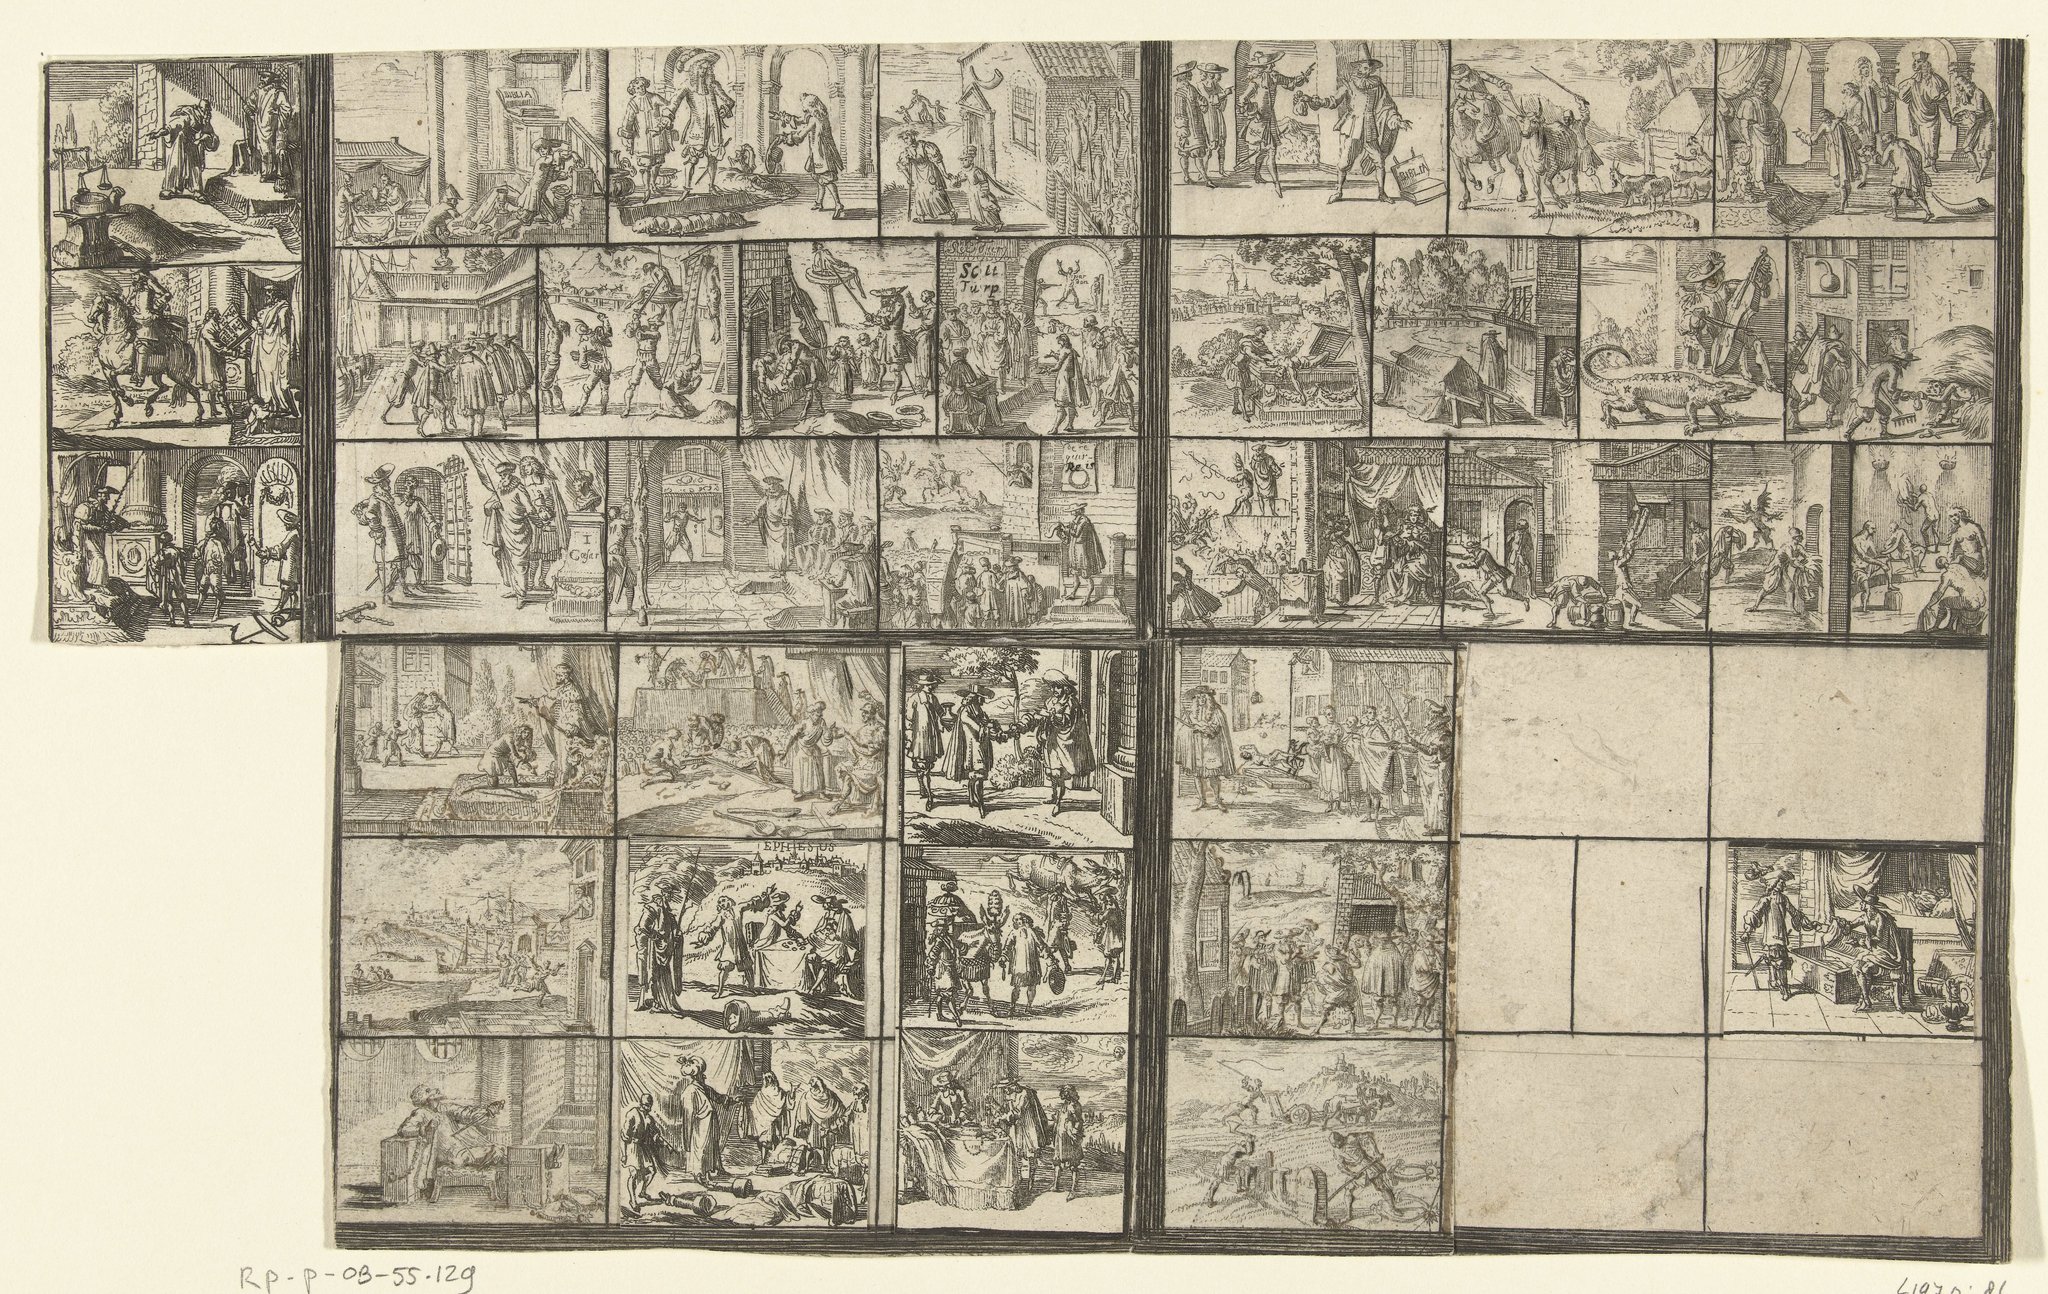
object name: print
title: Bladen met tientallen kleine voorstellingen van juridische aard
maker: romeyn de hooghe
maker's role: draughtsman, goldsmith, painter, print maker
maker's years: 1645-1708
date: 1690-1695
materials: paper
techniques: etching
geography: haarlem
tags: law and jurisprudence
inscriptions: collector's mark: Lugt 2228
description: Twee aan elkaar gelijmde delen van een blad dat waarschijnlijk oorspronkelijk een rechthoek was, onderverdeeld in tien vlakken, die zelf weer onderverdeeld waren in tien kleine vlakjes. In dit geval is een L-vormig deel vastgeplakt aan een klein rechthoekig deel, tezamen goed voor ruim vier vlakken, drieënveertig kleine vlakjes. Zestien van die kleine vakjes zijn leeg gelaten (in tien daarvan zijn uitgeknipte plaatjes van een ander blad geplakt), zevenentwintig zijn gevuld met kleine voorstellingen van juridische aard. Zo zijn er bijvoorbeeld transacties, contracten etc. afgebeeld. Dit blad is onderdeel van een serie bladen met telkens (ruimte voor) tien maal tien kleine juridische voorstellingen. Mogelijk betreft het illustraties voor een boek.